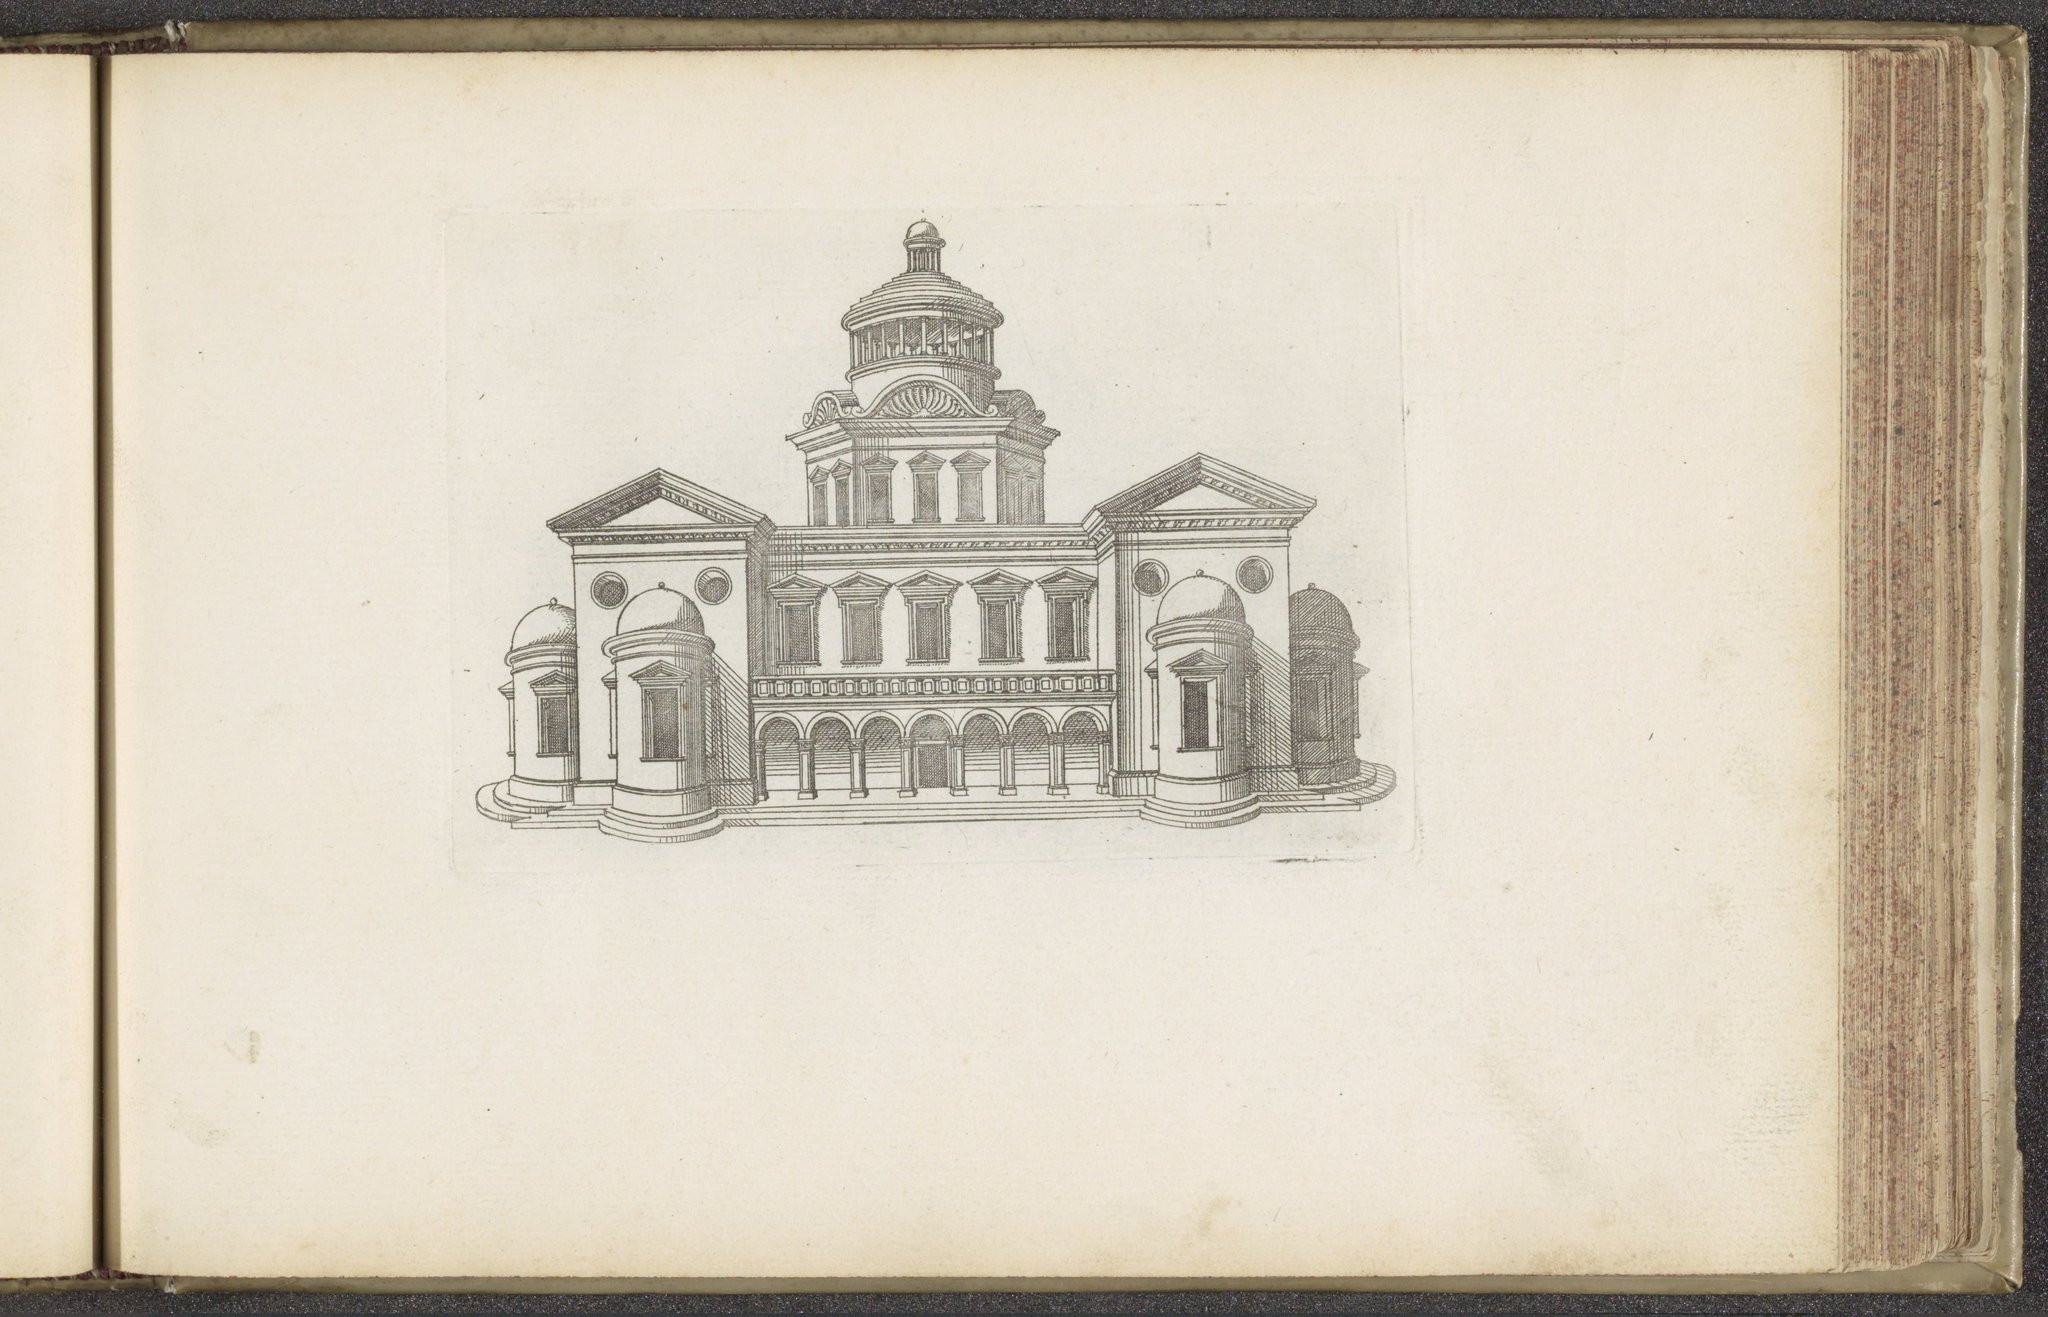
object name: print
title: Tempels en kerken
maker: jacques androuet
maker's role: draughtsman, print maker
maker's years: 1515-1584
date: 1550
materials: paper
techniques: etching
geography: orléans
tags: exterior ~ representation of a building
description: Heiligdom met een centrale koepel. Links en rechts apsissen. Deze prent maakt deel uit van een album.